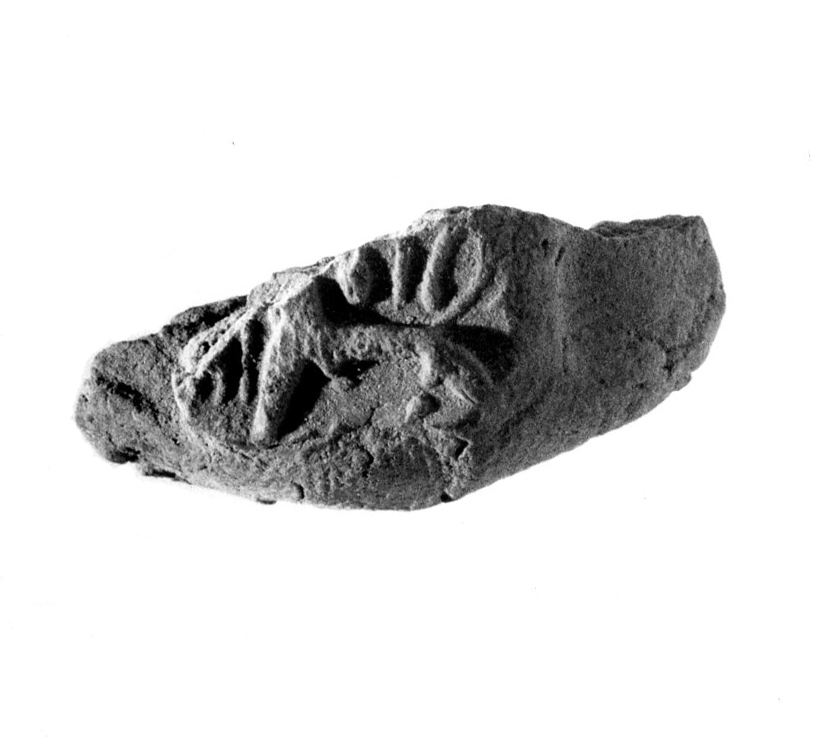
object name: sealing, thutmose iii, menkheperre, lion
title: Document Sealings With the Throne Name of Thutmose III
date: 1390-1352 BCE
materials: mud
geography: egypt